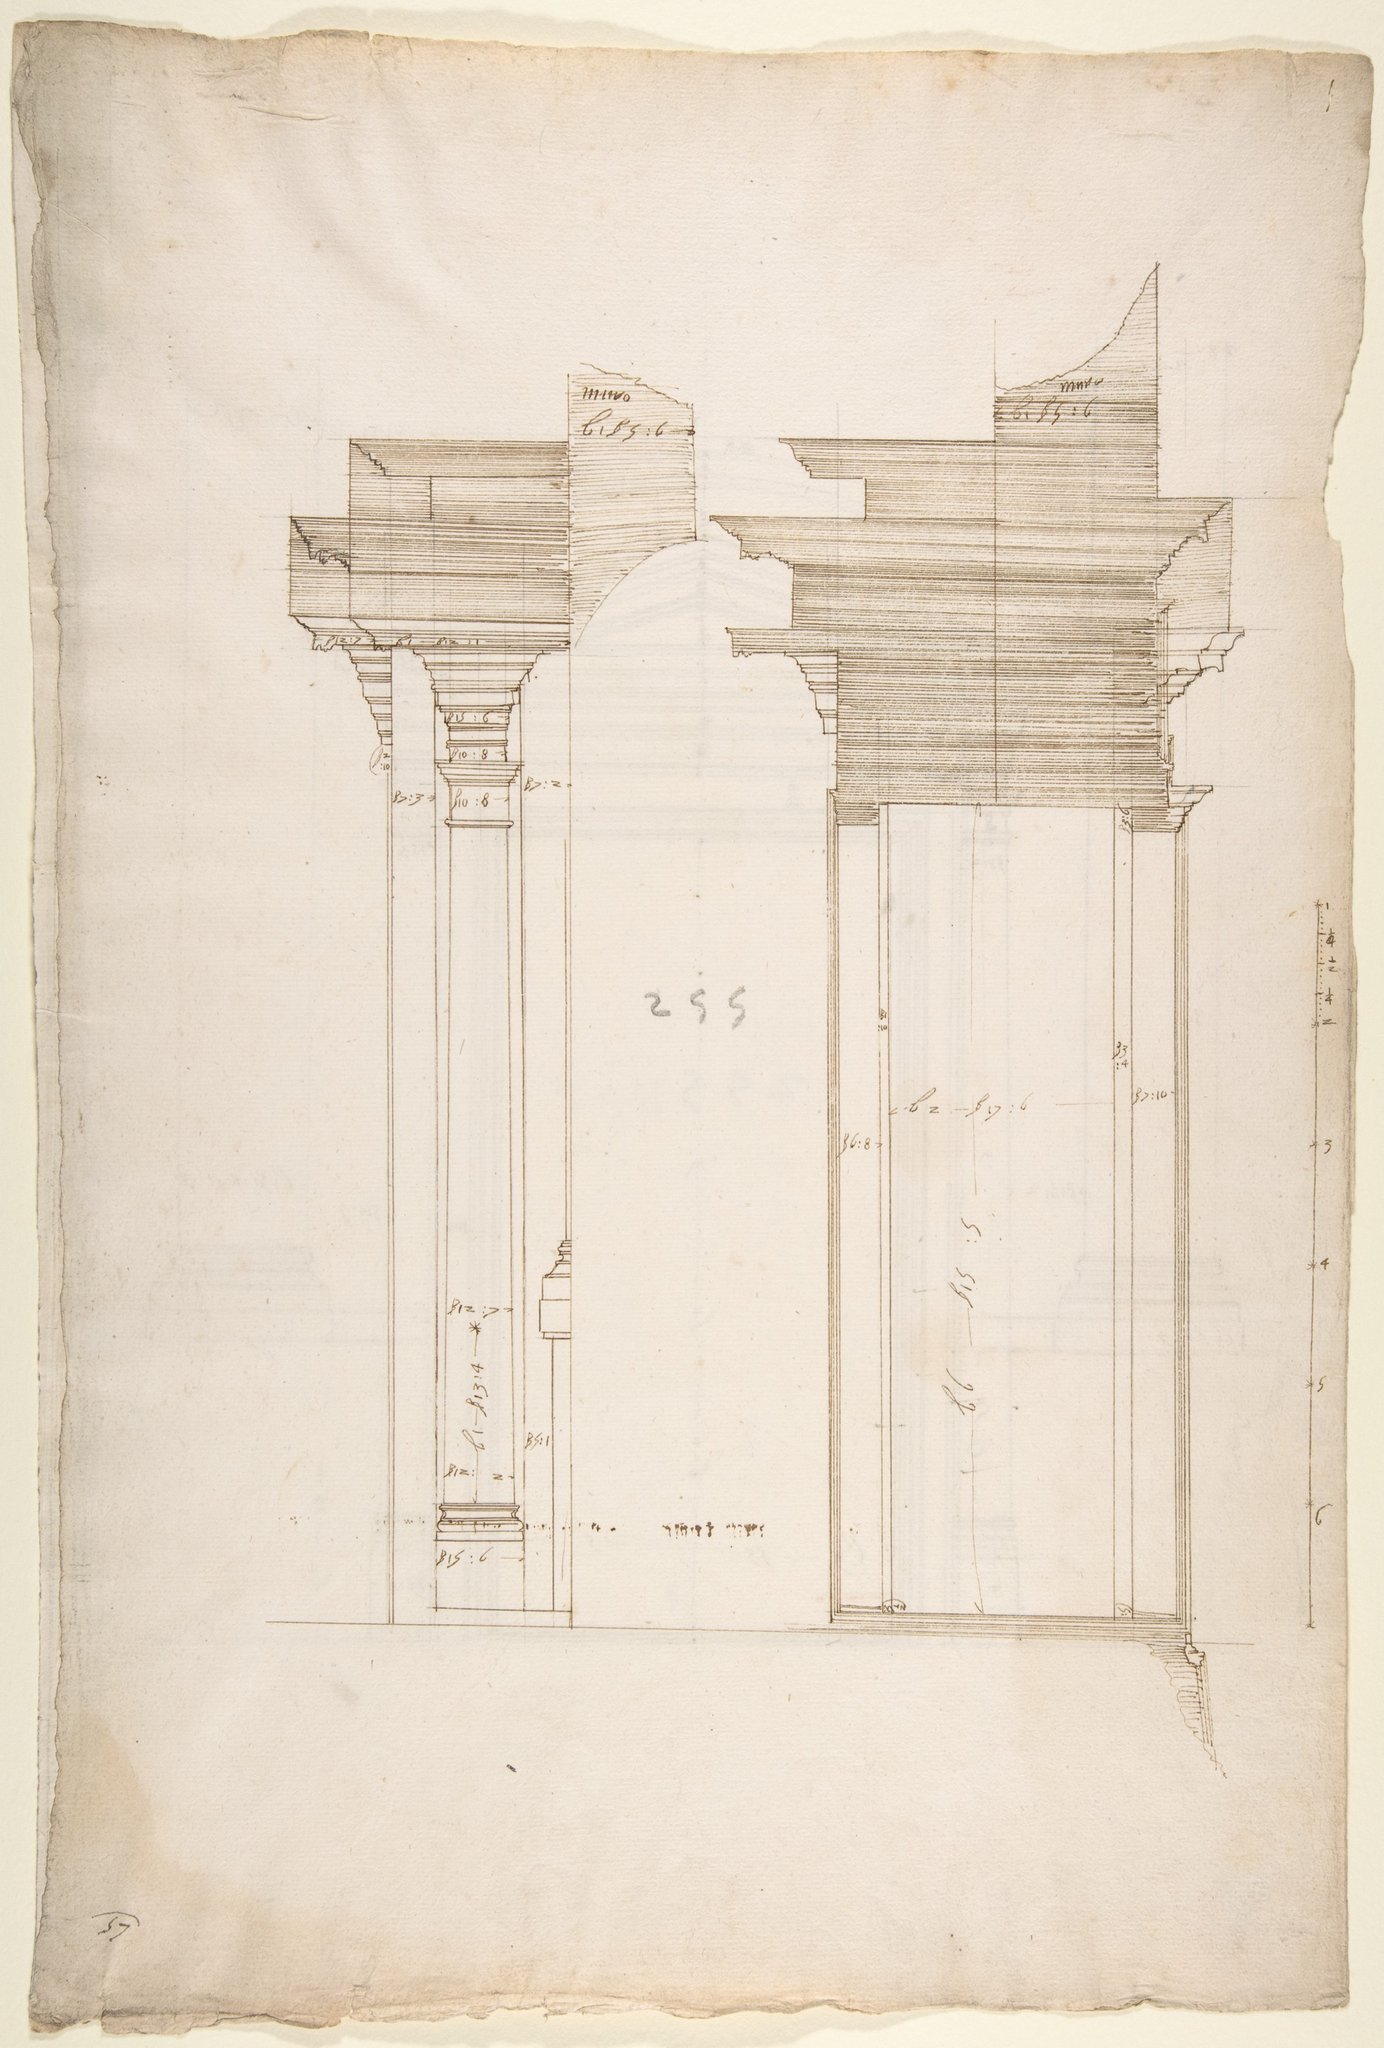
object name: drawing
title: San Lorenzo, Library, portal, section (recto) San Lorenzo, Library, Ricetto, portal, elevation (verso)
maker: anonymous, french, 16th century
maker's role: draftsman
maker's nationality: french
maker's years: 1500-1600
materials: chalk, ink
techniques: incising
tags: architecture